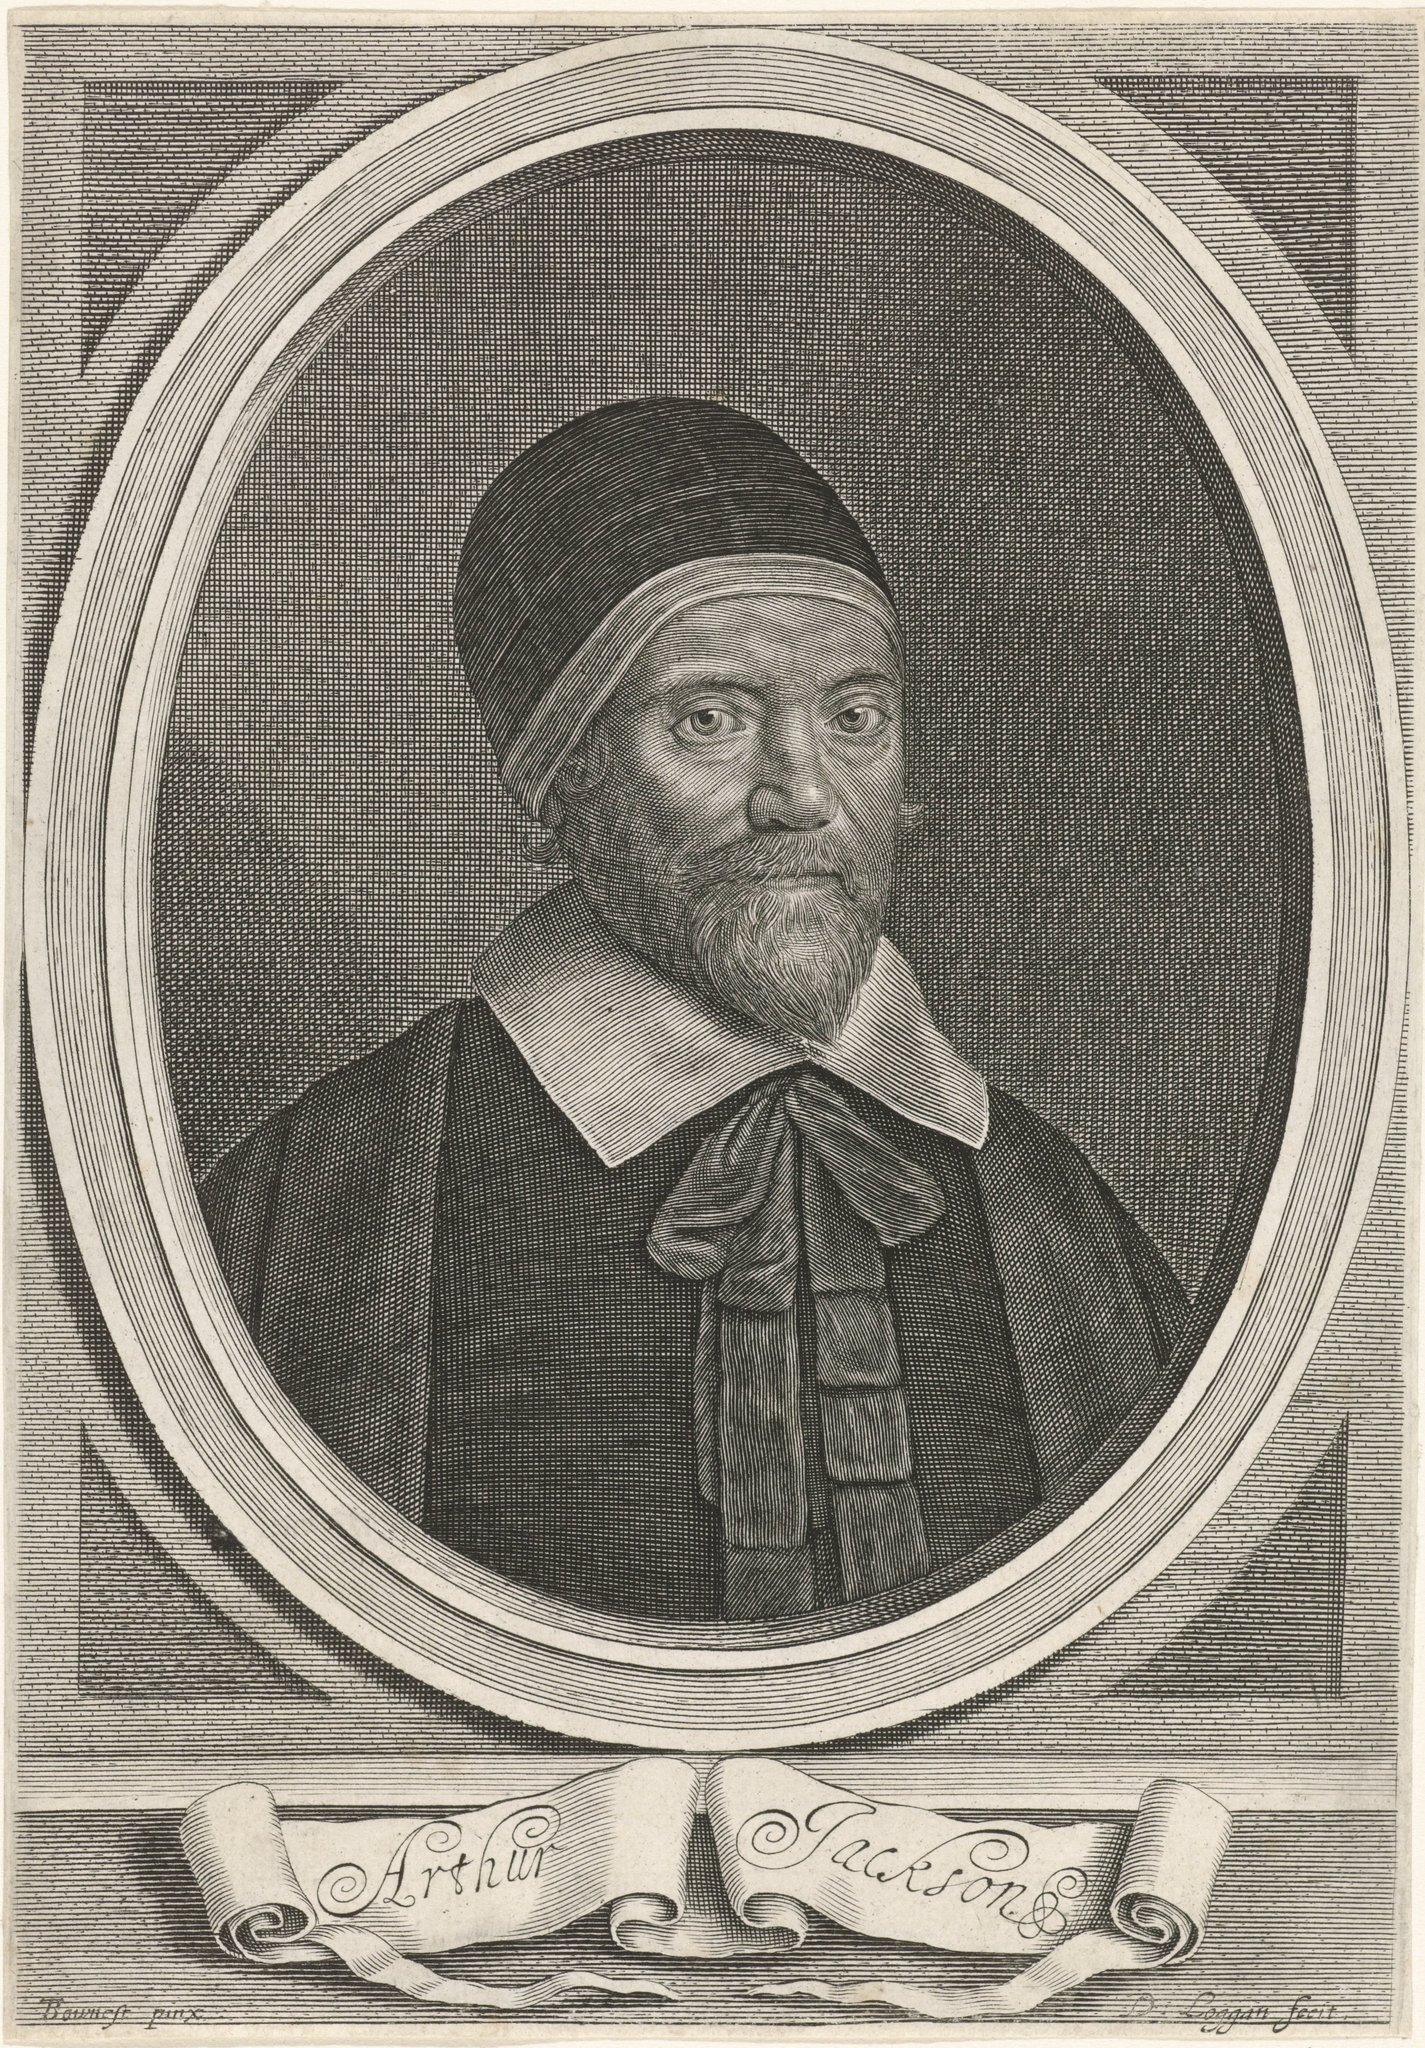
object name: print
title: Portret van Arthur Jackson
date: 1643-1692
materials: paper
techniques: engraving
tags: clergyman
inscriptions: collector's mark: Lugt 2760, collector's mark: Lugt 2228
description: Portret van de Engelse geestelijke Arthur Jackson.